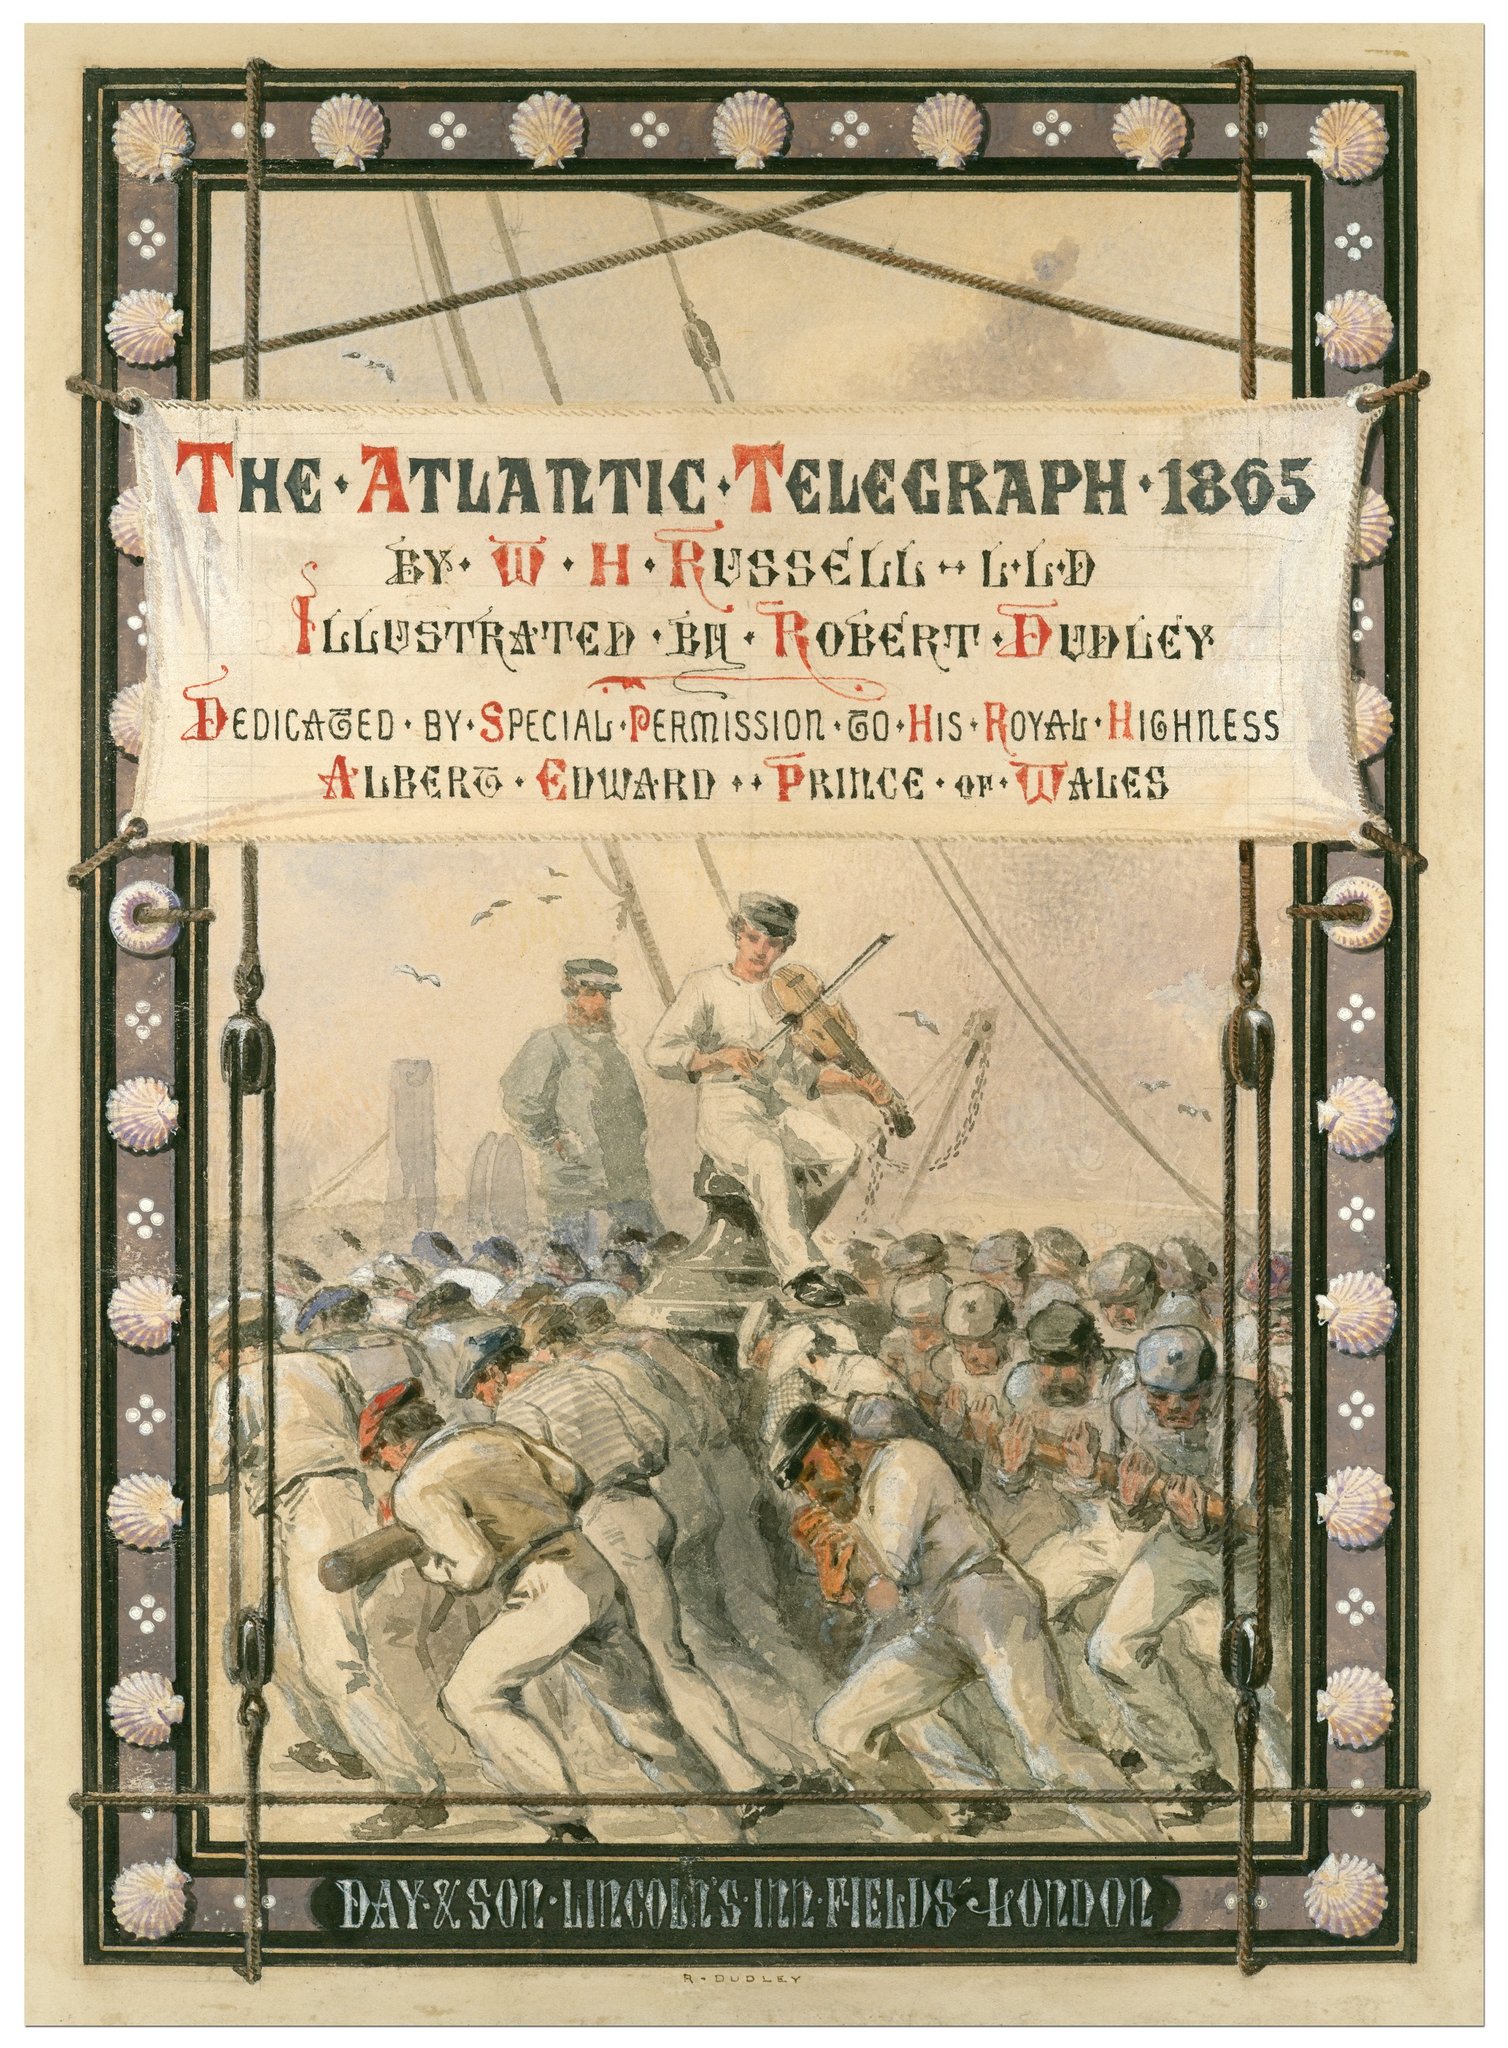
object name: book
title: The Atlantic Telegraph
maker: sir william howard russell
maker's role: author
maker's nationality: irish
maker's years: 1820-1907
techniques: lithograph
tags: men,transatlantic cable